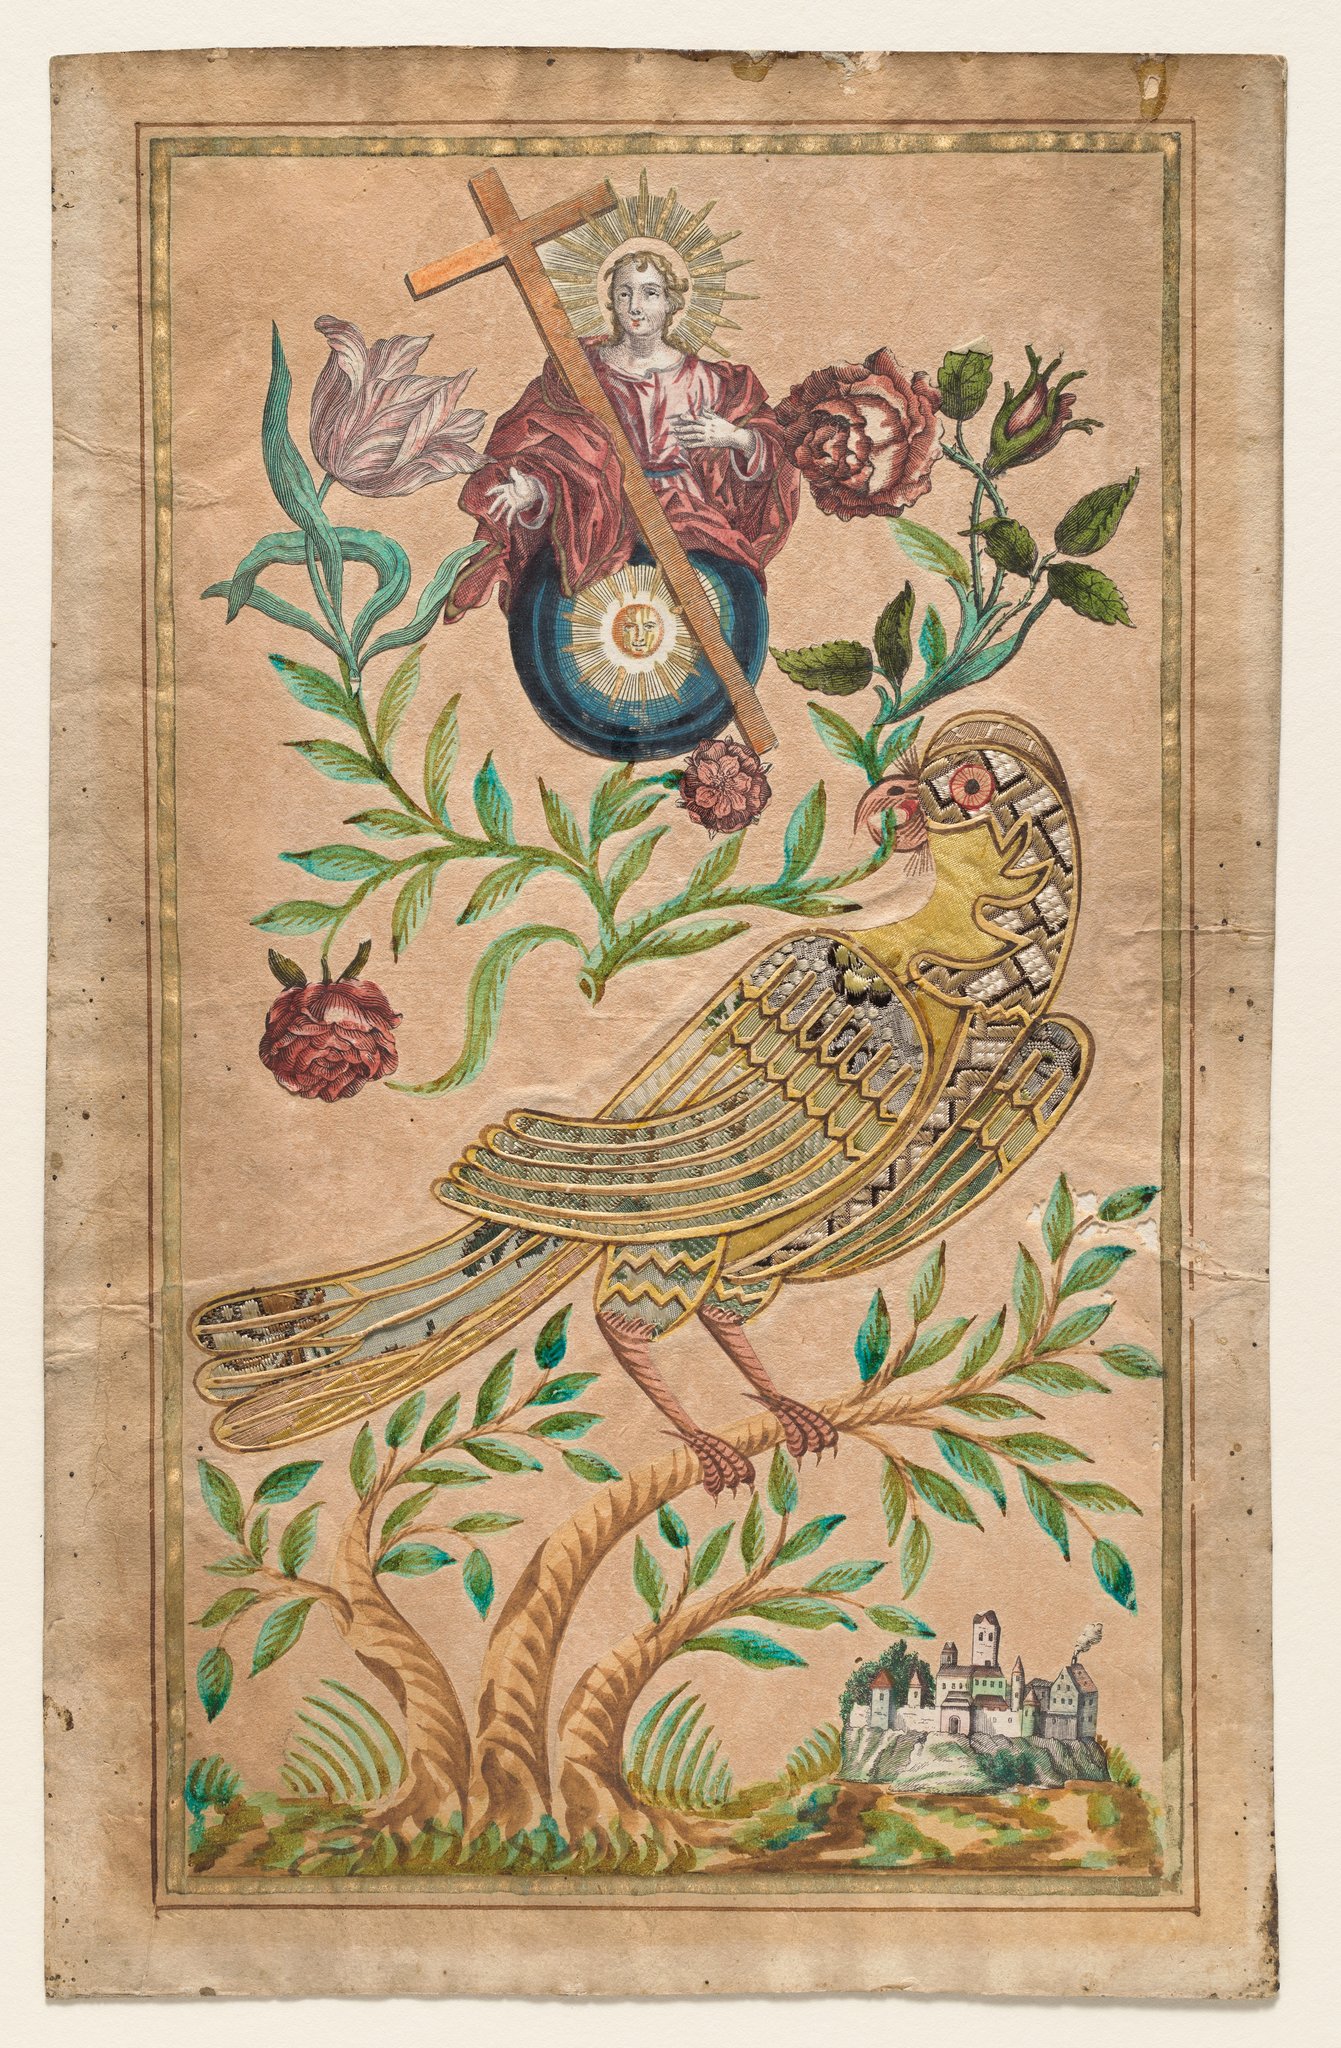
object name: cut paper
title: Christ with the Cross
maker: anonymous, german, 18th century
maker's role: artist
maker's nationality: german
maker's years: 1700-1800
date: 1701-1800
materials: paint, paper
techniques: engraving, hand coloring